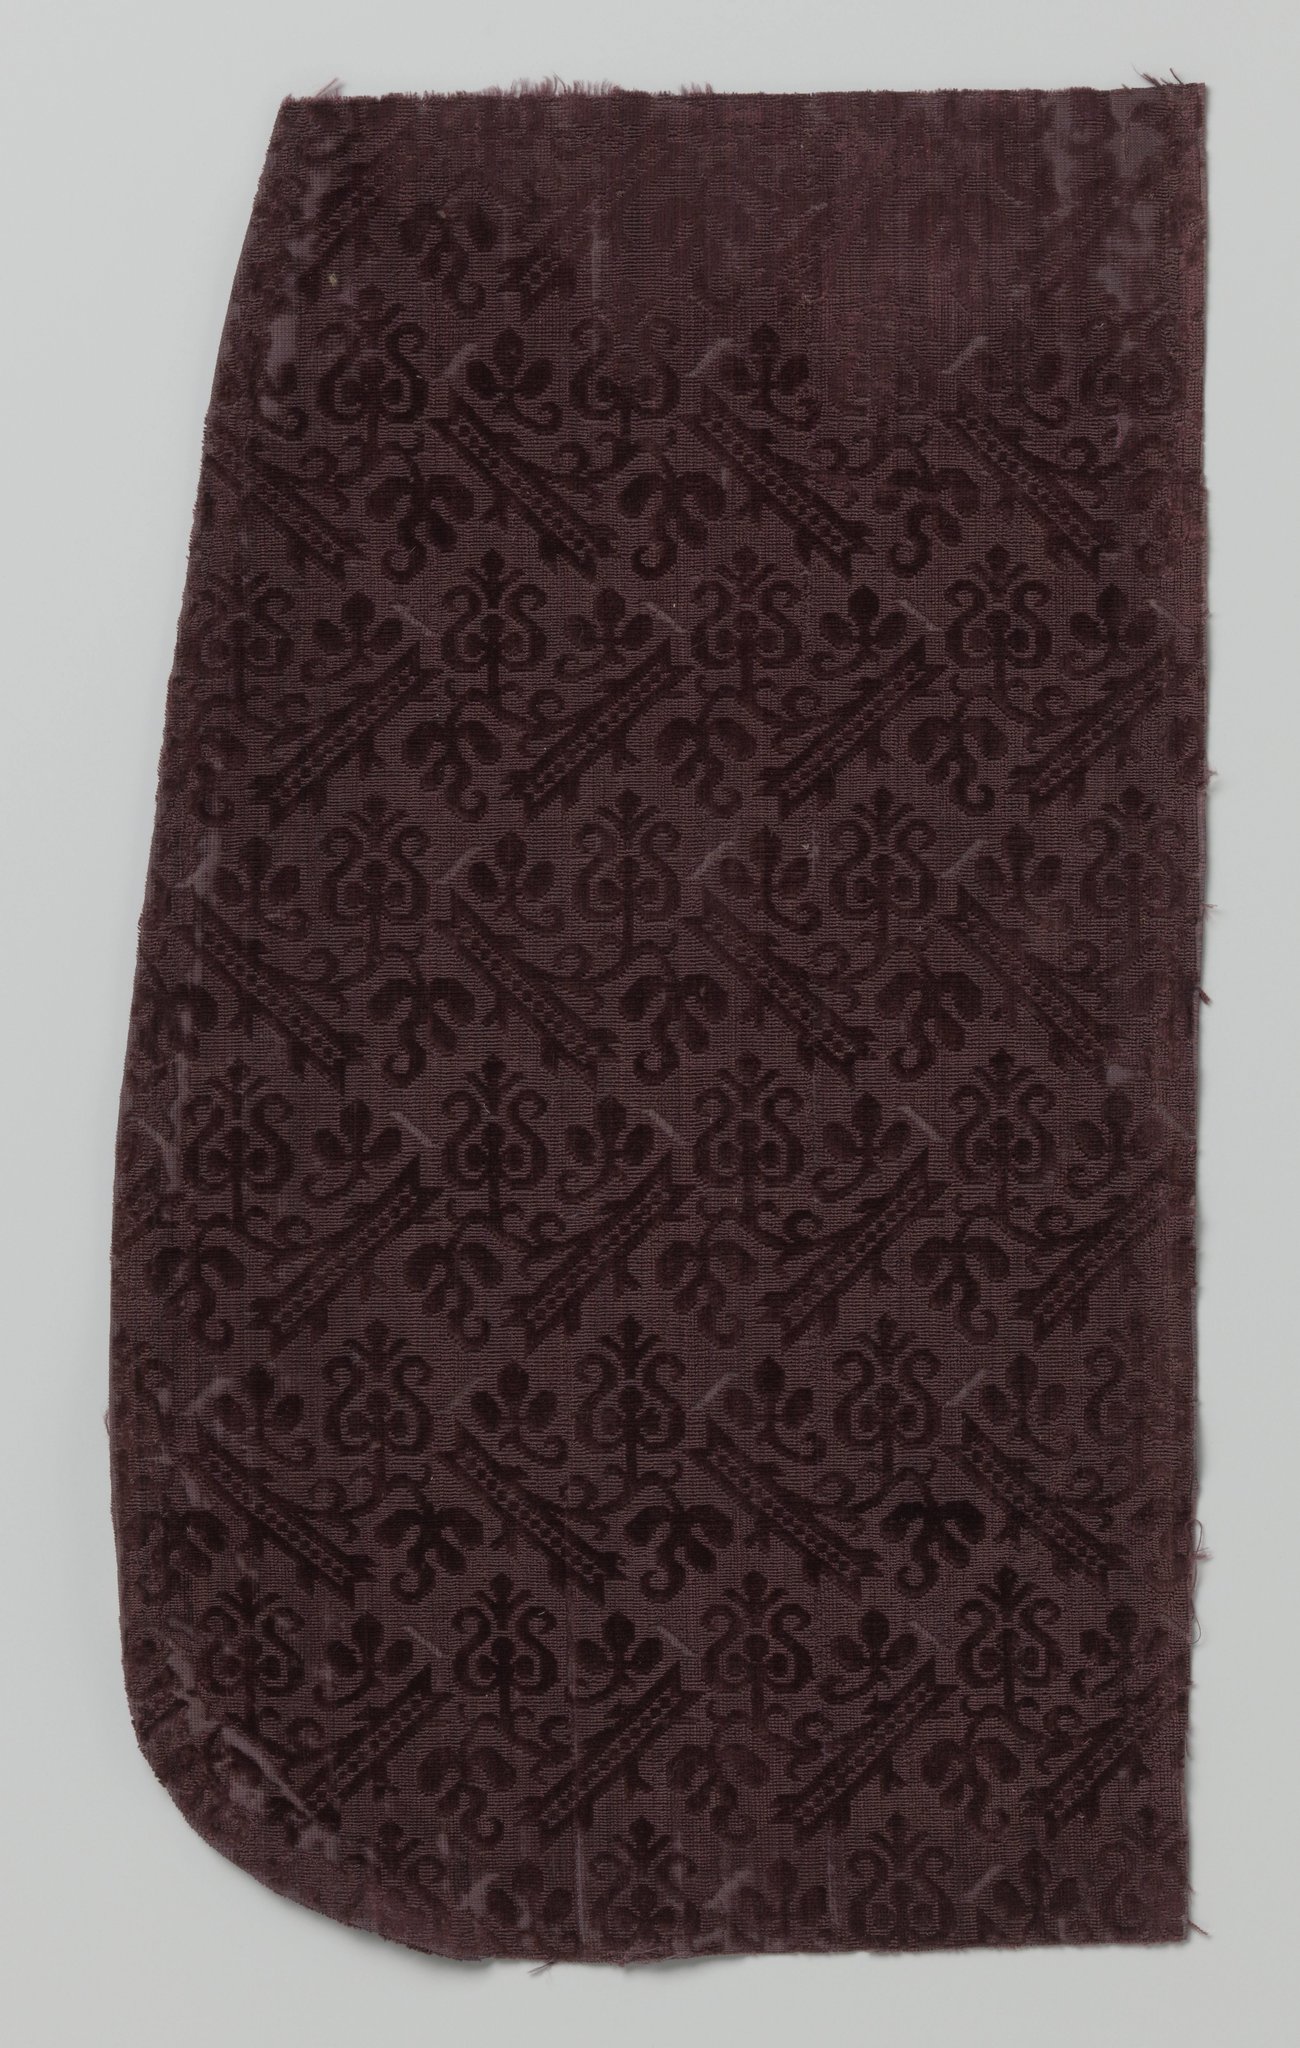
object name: zijdefluweel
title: Fragment rood zijdefluweel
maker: Anonymous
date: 1500-1599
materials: ciselé velvet, silk, velvet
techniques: weave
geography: italy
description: Een fragment van een fluweel. In wijnrood fluweel horizontaal gerijde gestileerde bladen en bloemen aan takjes aan balkvormige uiteinden.